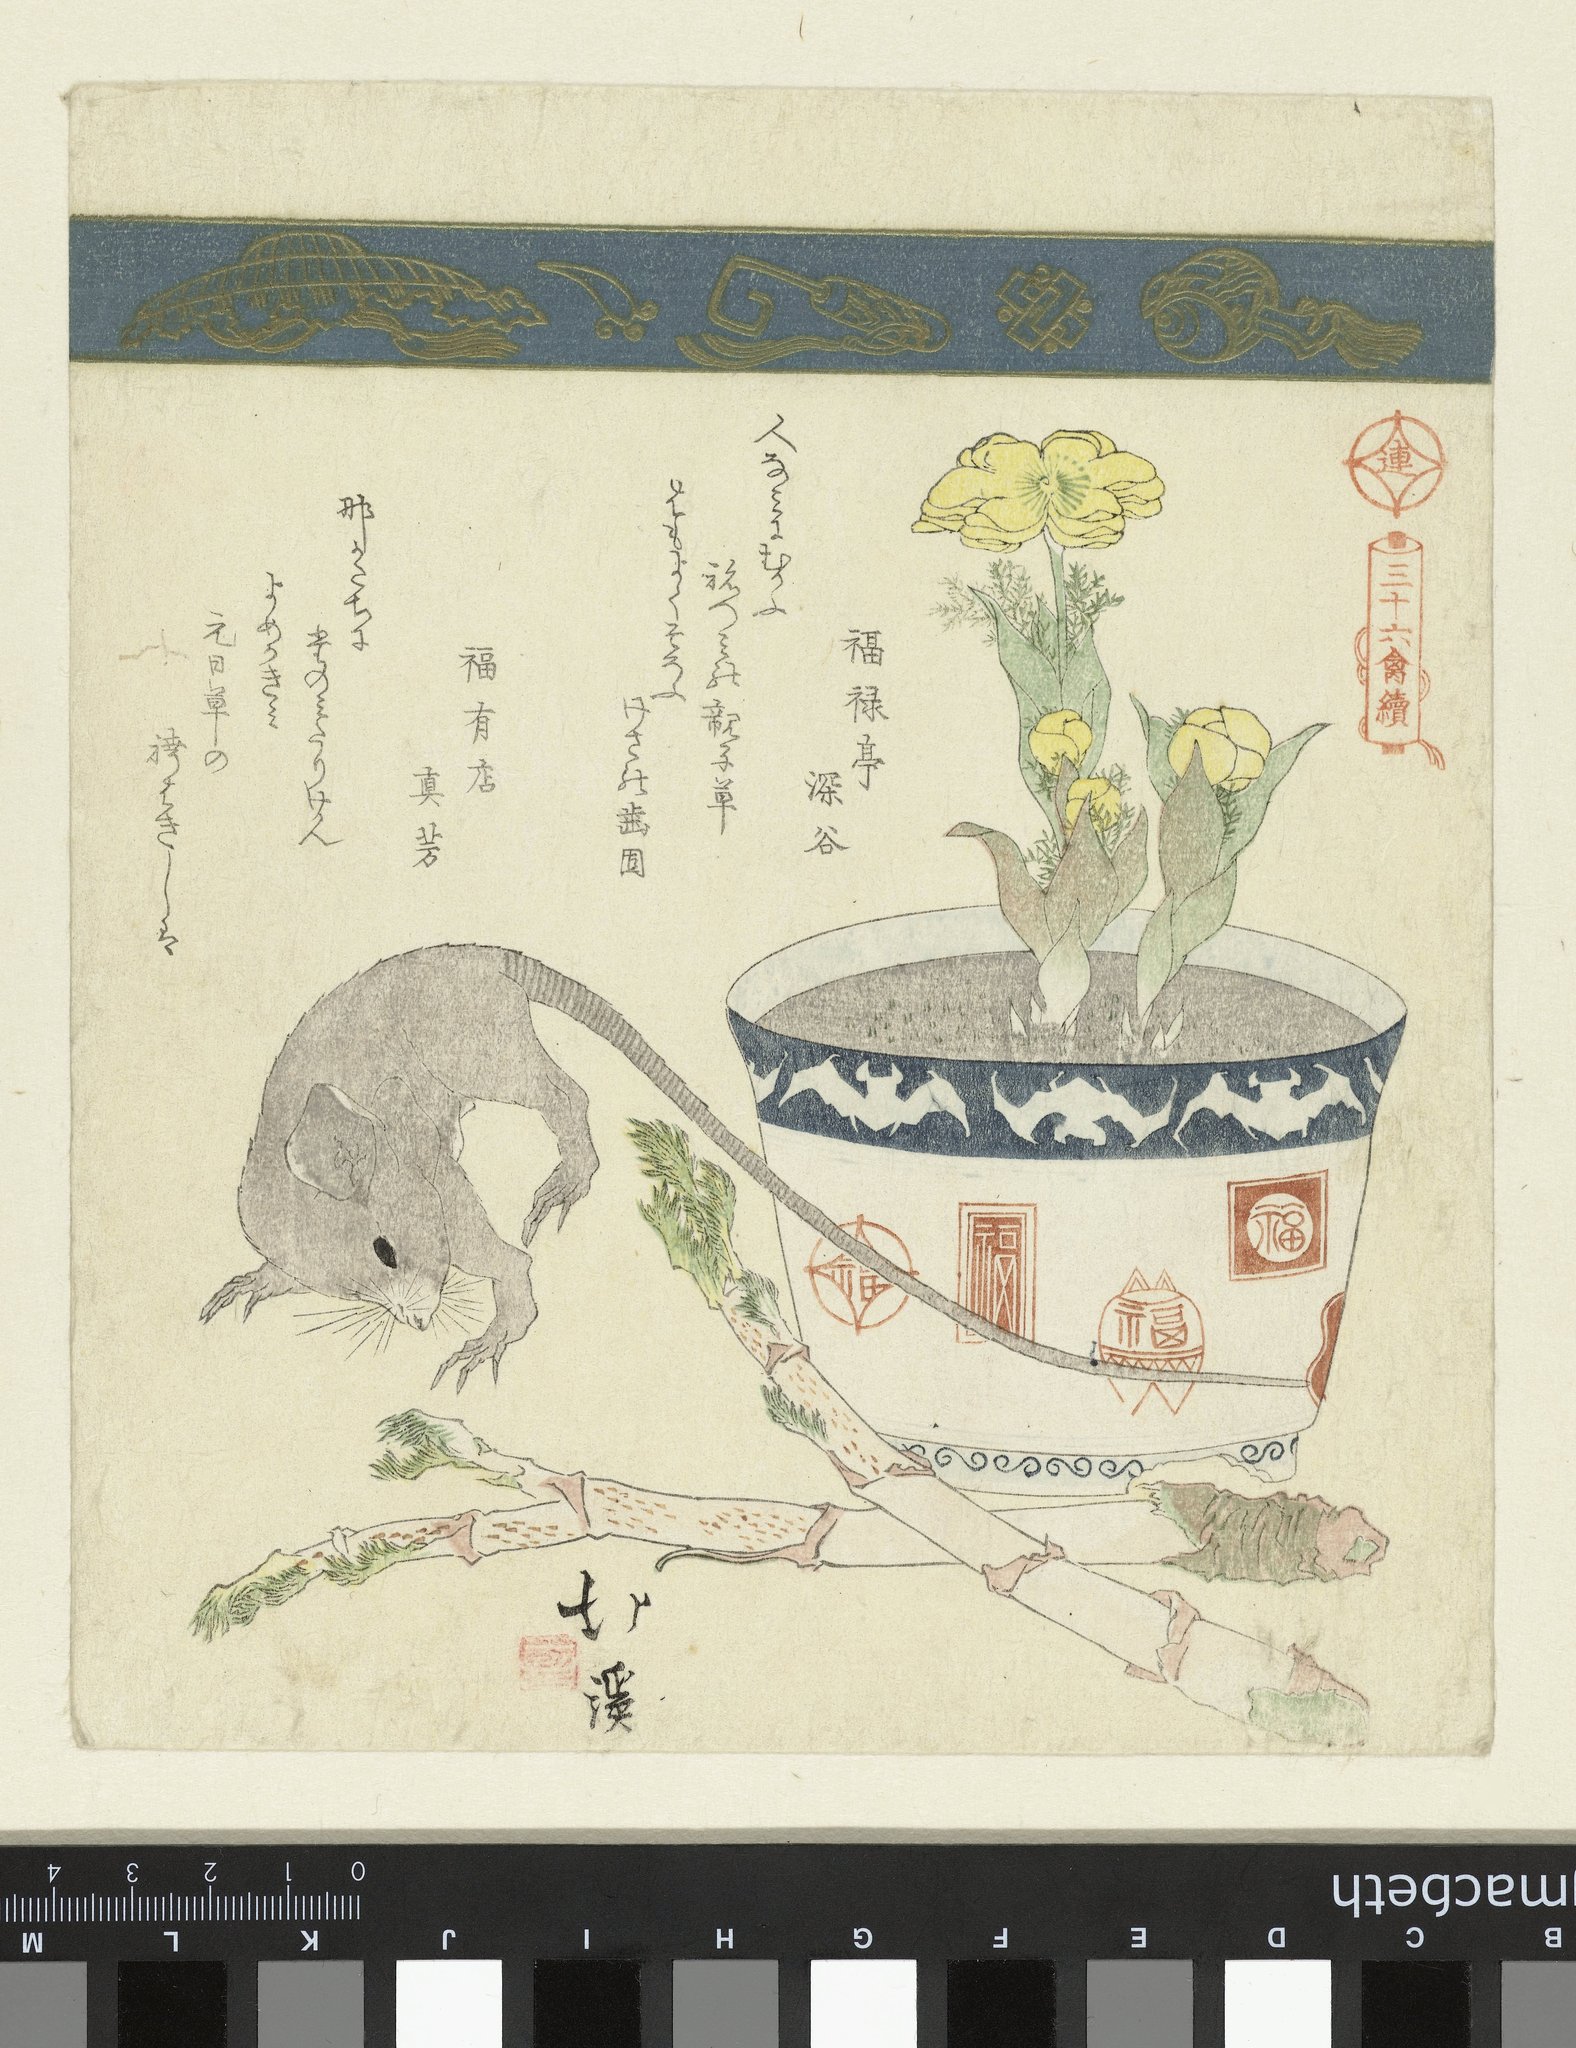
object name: print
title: Een serie van zesendertig vogels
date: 1828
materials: paper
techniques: woodcut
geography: japan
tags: rodents: rat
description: Een surimono is een luxe uitgevoerde prent waarop beeld met één of meerdere gedichten gecombineerd is. Bij het drukken van een surimono werd vaak gebruik gemaakt van dikker papier, blinddruk en metaal pigmenten, zoals koper- en zilverpoeder. De prenten werden vaak in opdracht van dichters gemaakt en als exclusief geschenk aan vrienden en relaties gegeven.